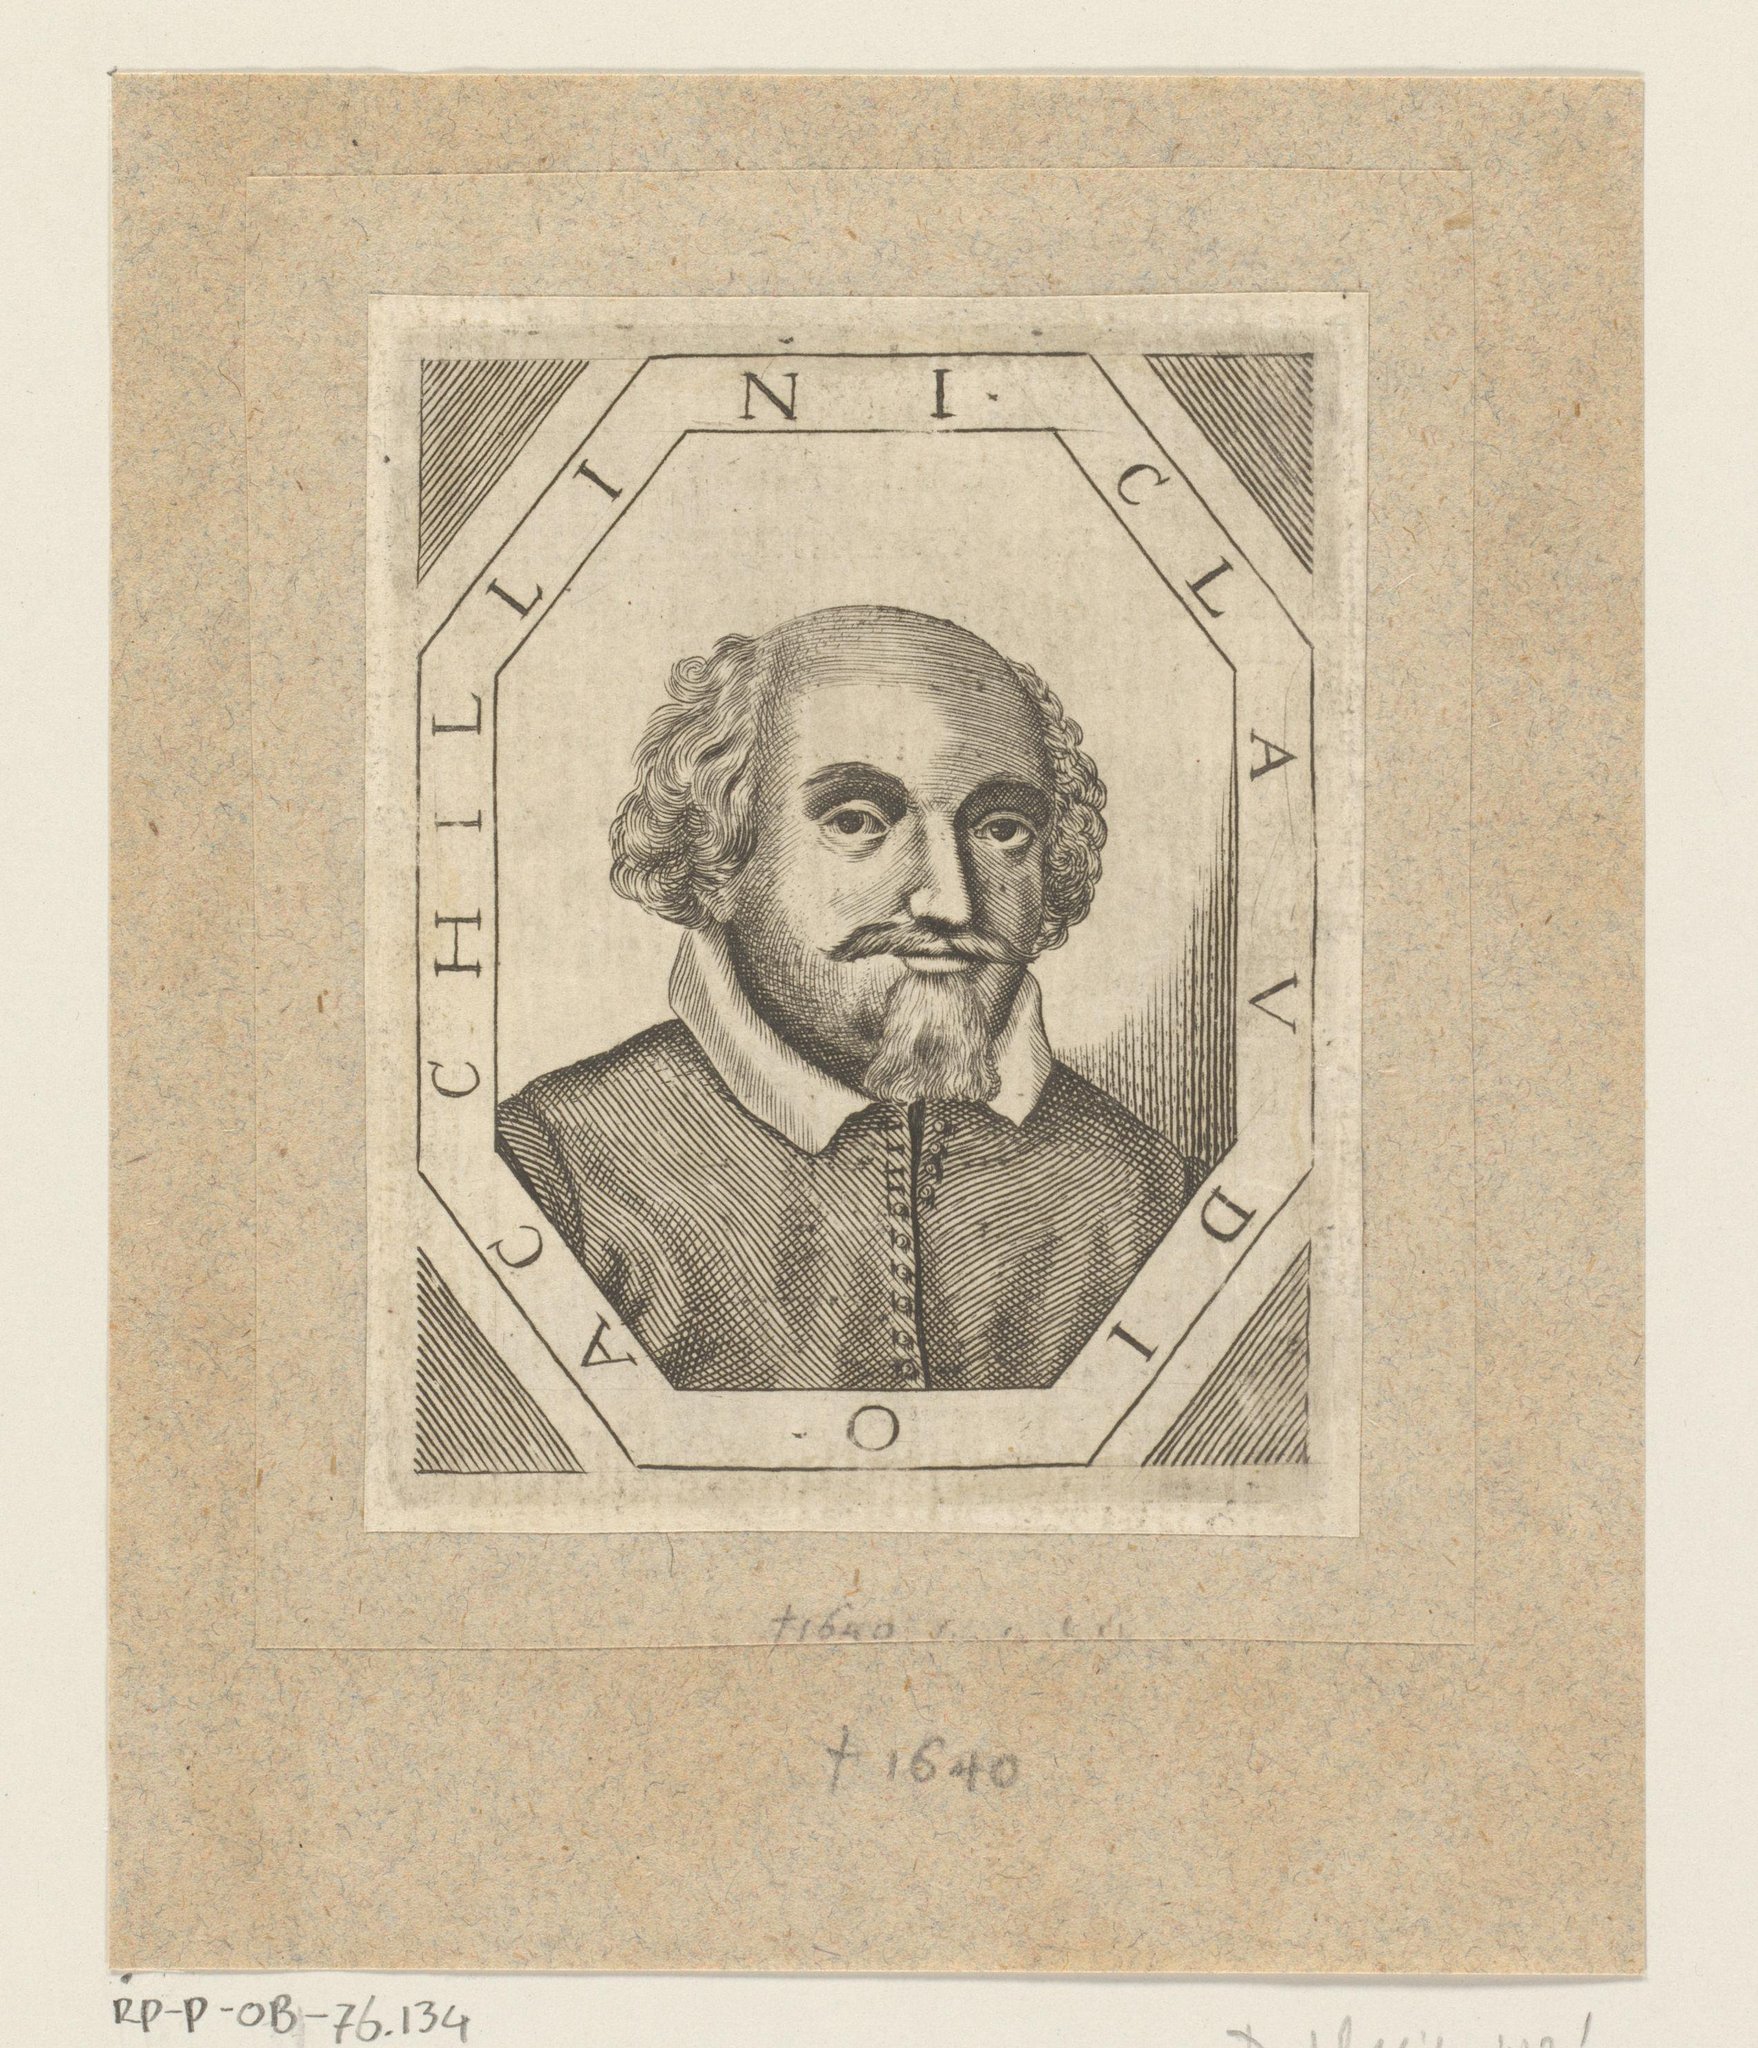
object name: print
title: Portret van filosoof Claudio Achillini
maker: Anonymous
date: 1666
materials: paper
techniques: engraving, letterpress printing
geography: venice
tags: scholar, philosopher, historical persons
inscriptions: inscription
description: Prent uit: Crasso, Lorenzo. Elogii degli huomini letterati scritti. Venetië: Combi & la Noù, 1666, dl. 2, p. 162.